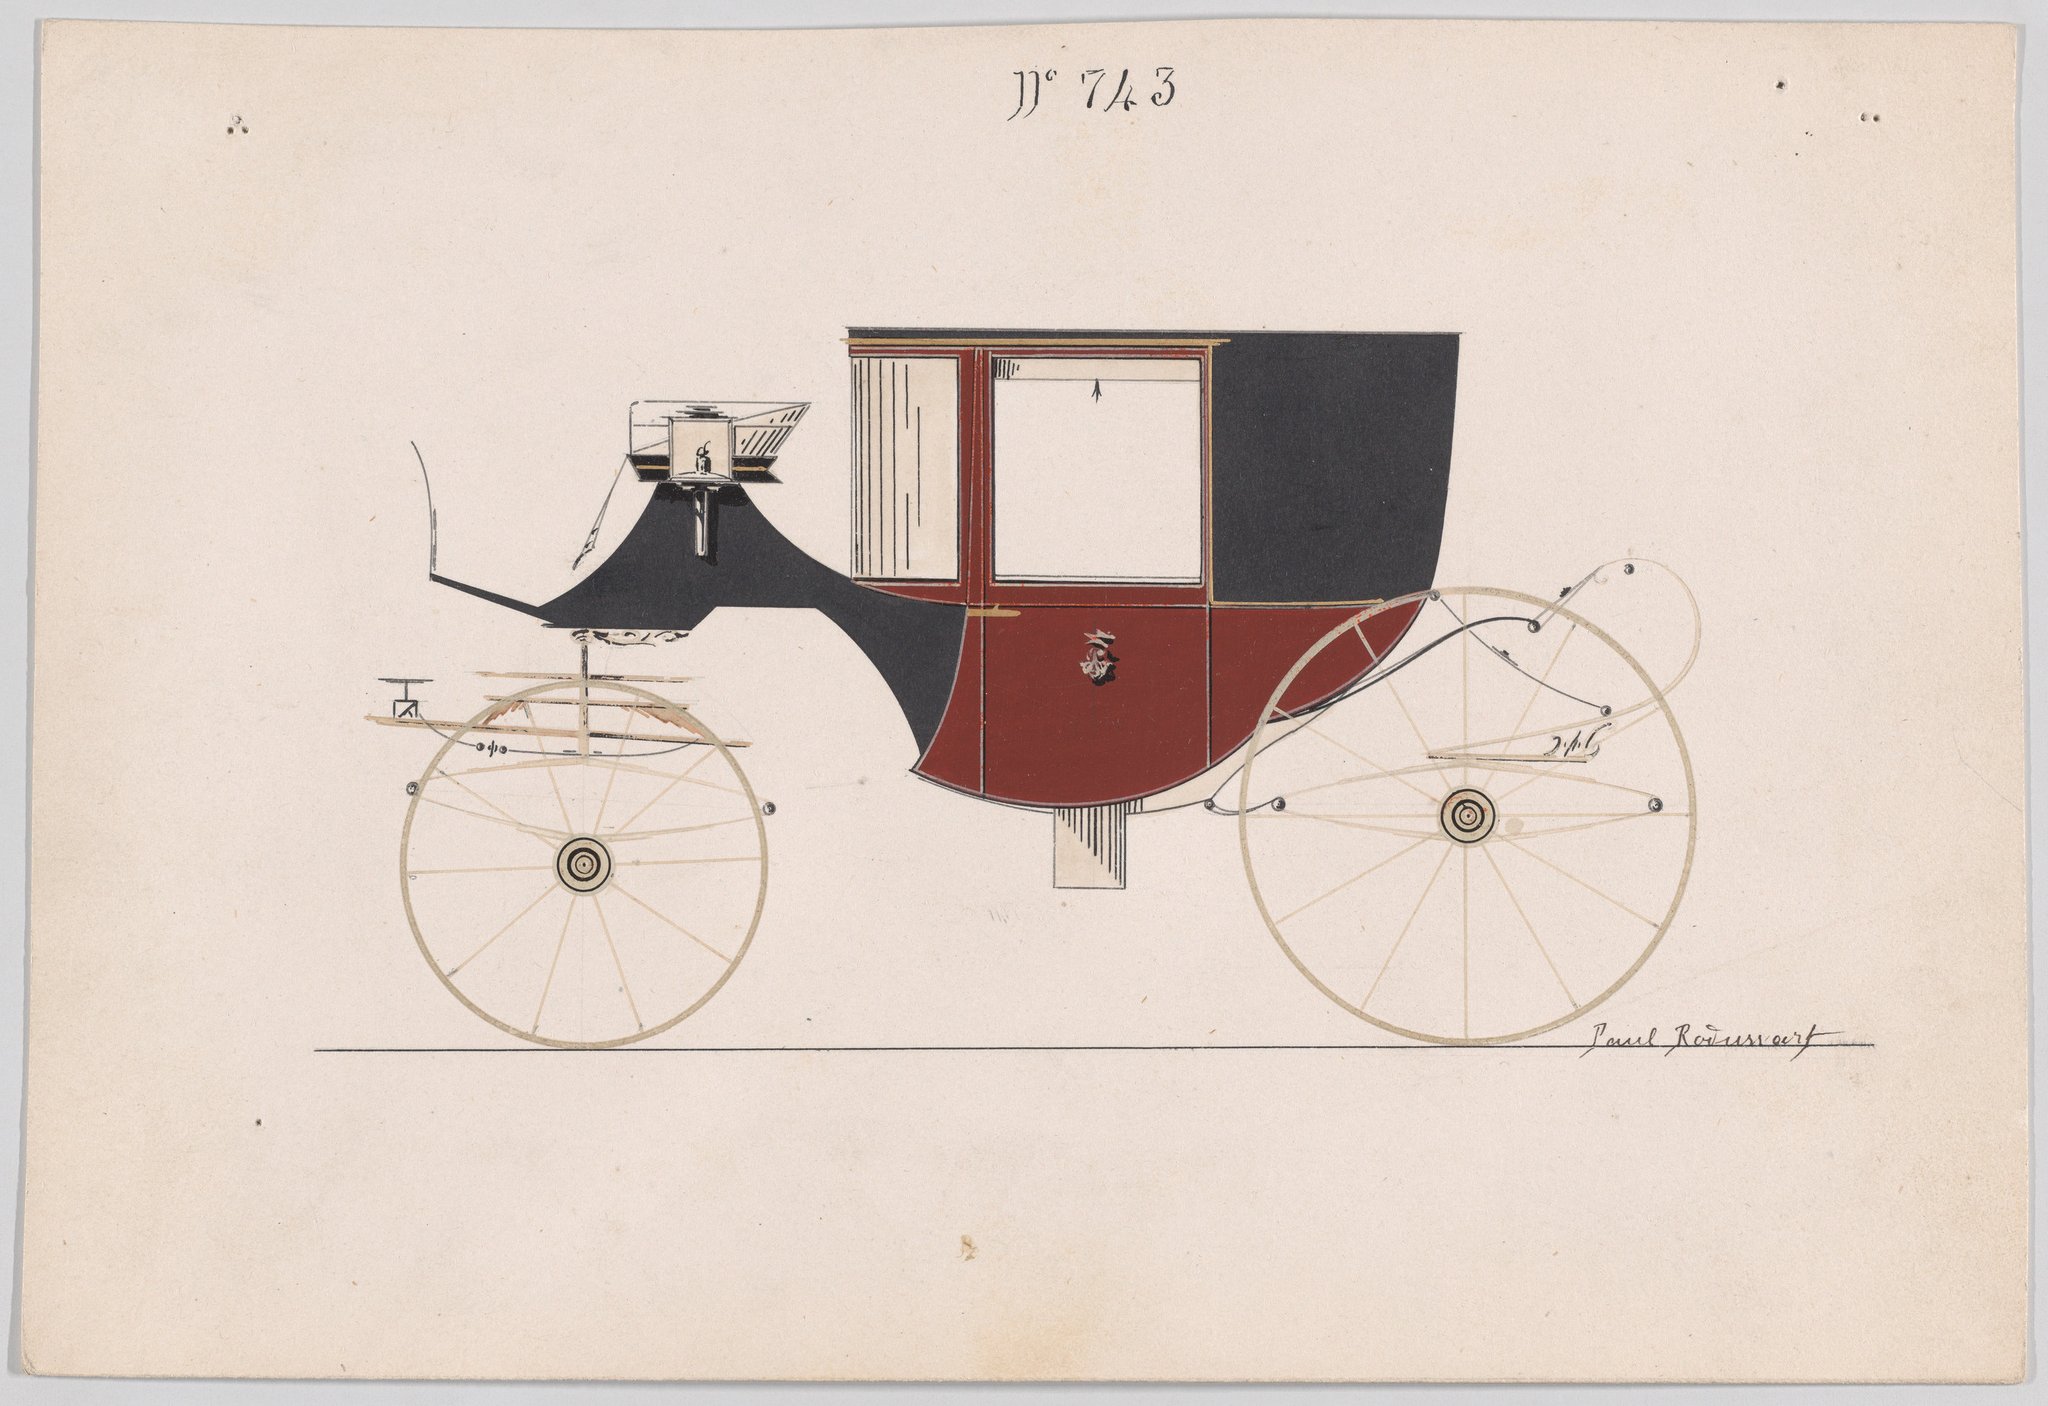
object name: drawing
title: Clarence # 743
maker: brewster & co.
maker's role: manufacturer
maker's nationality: american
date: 1850-1870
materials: gouache, gum arabic, ink, watercolor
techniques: pen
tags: carriages